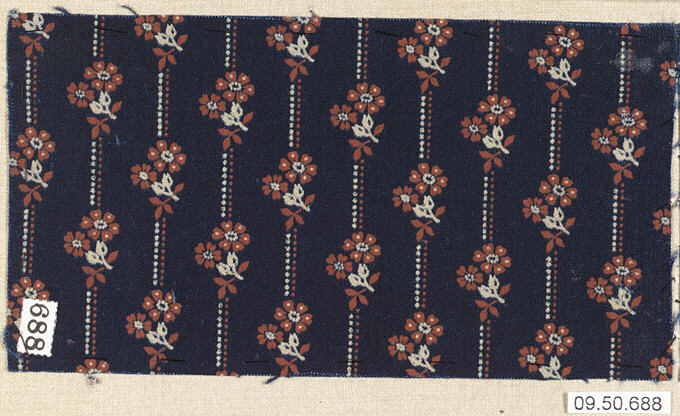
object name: piece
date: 1801-1900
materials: cotton